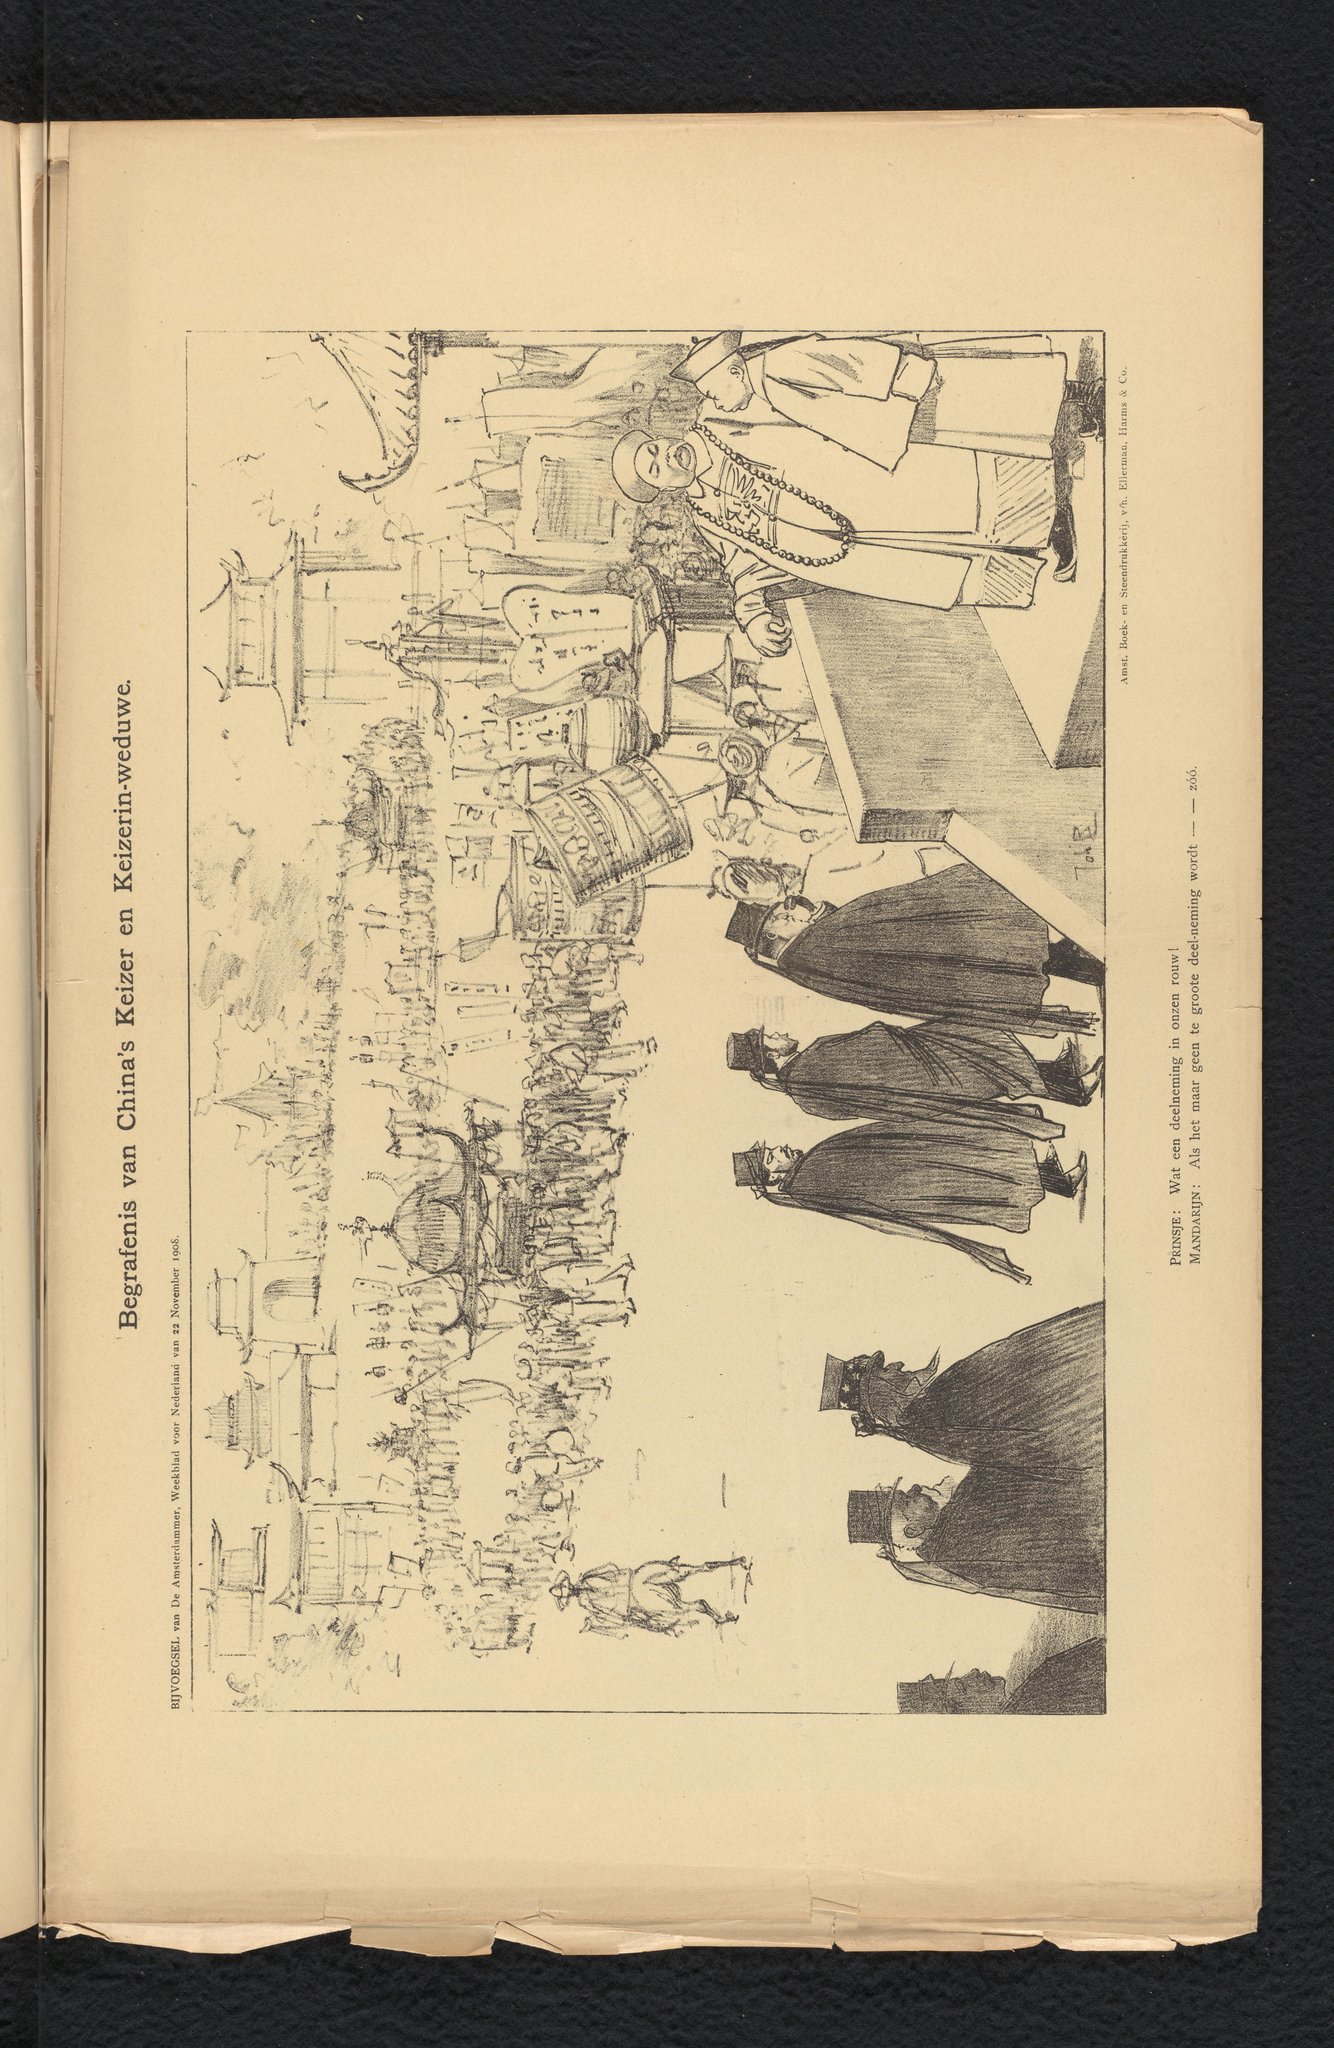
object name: cartoon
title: Begrafenis van China's Keizer en Keizerin-weduwe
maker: johan braakensiek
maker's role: draughtsman, print maker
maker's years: 1858-1940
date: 1908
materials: paper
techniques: lithograph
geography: netherlands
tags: cixi (keizerin-regentes van china), personifications of countries, nations, states, districts, etc., cortege, funeral procession, political caricatures and satires, china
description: Vertegenwoordigers van de grote mogendheden lopen in de begrafenisstoet van keizer Guangxu en keizerin Cixi, overleden op 14 en 15 november 1908. Vanaf een verhoging zien de jonge prins Puyi (keizer Xuantong) en een Mandarijn toe, bezorgd over de inhaligheid van andere landen.